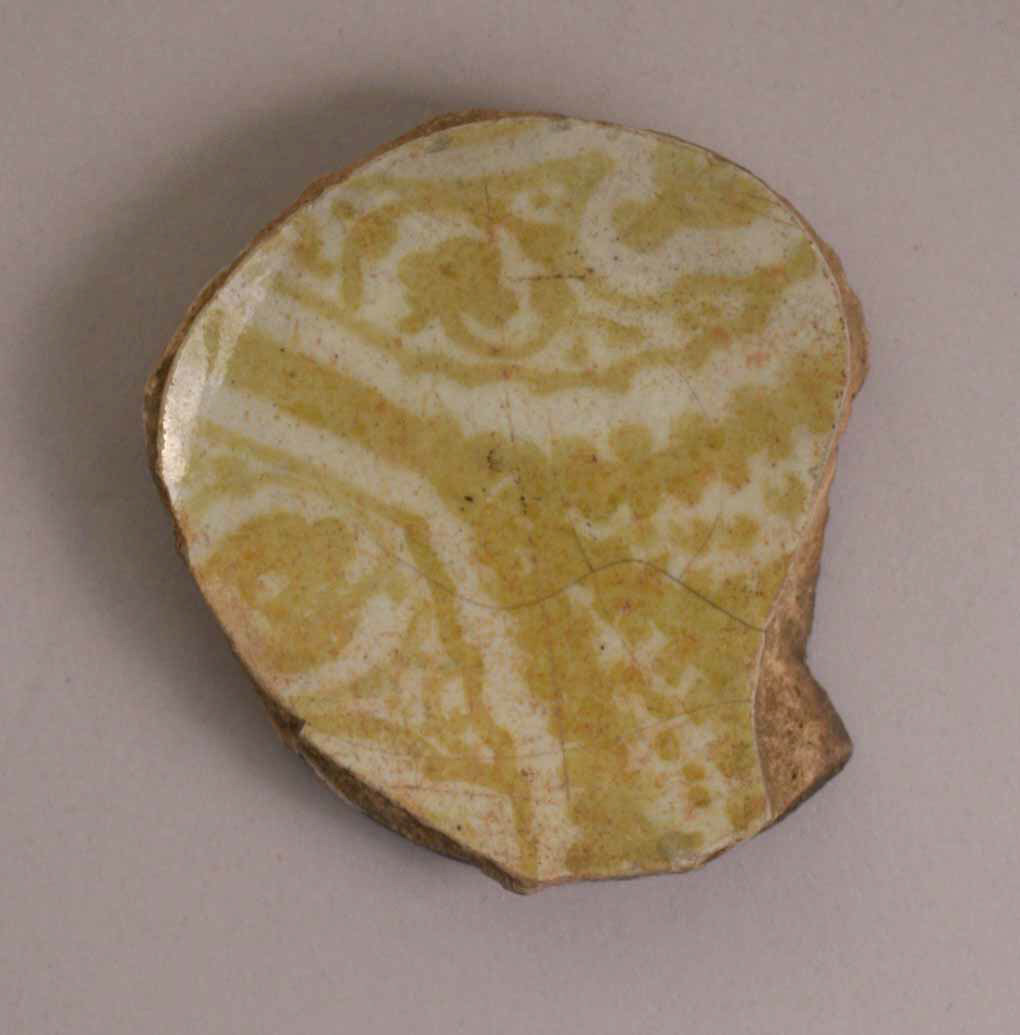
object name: ceramic fragment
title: Fragment of Dish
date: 1001-1200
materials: stonepaste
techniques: glazing, luster painting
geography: syria